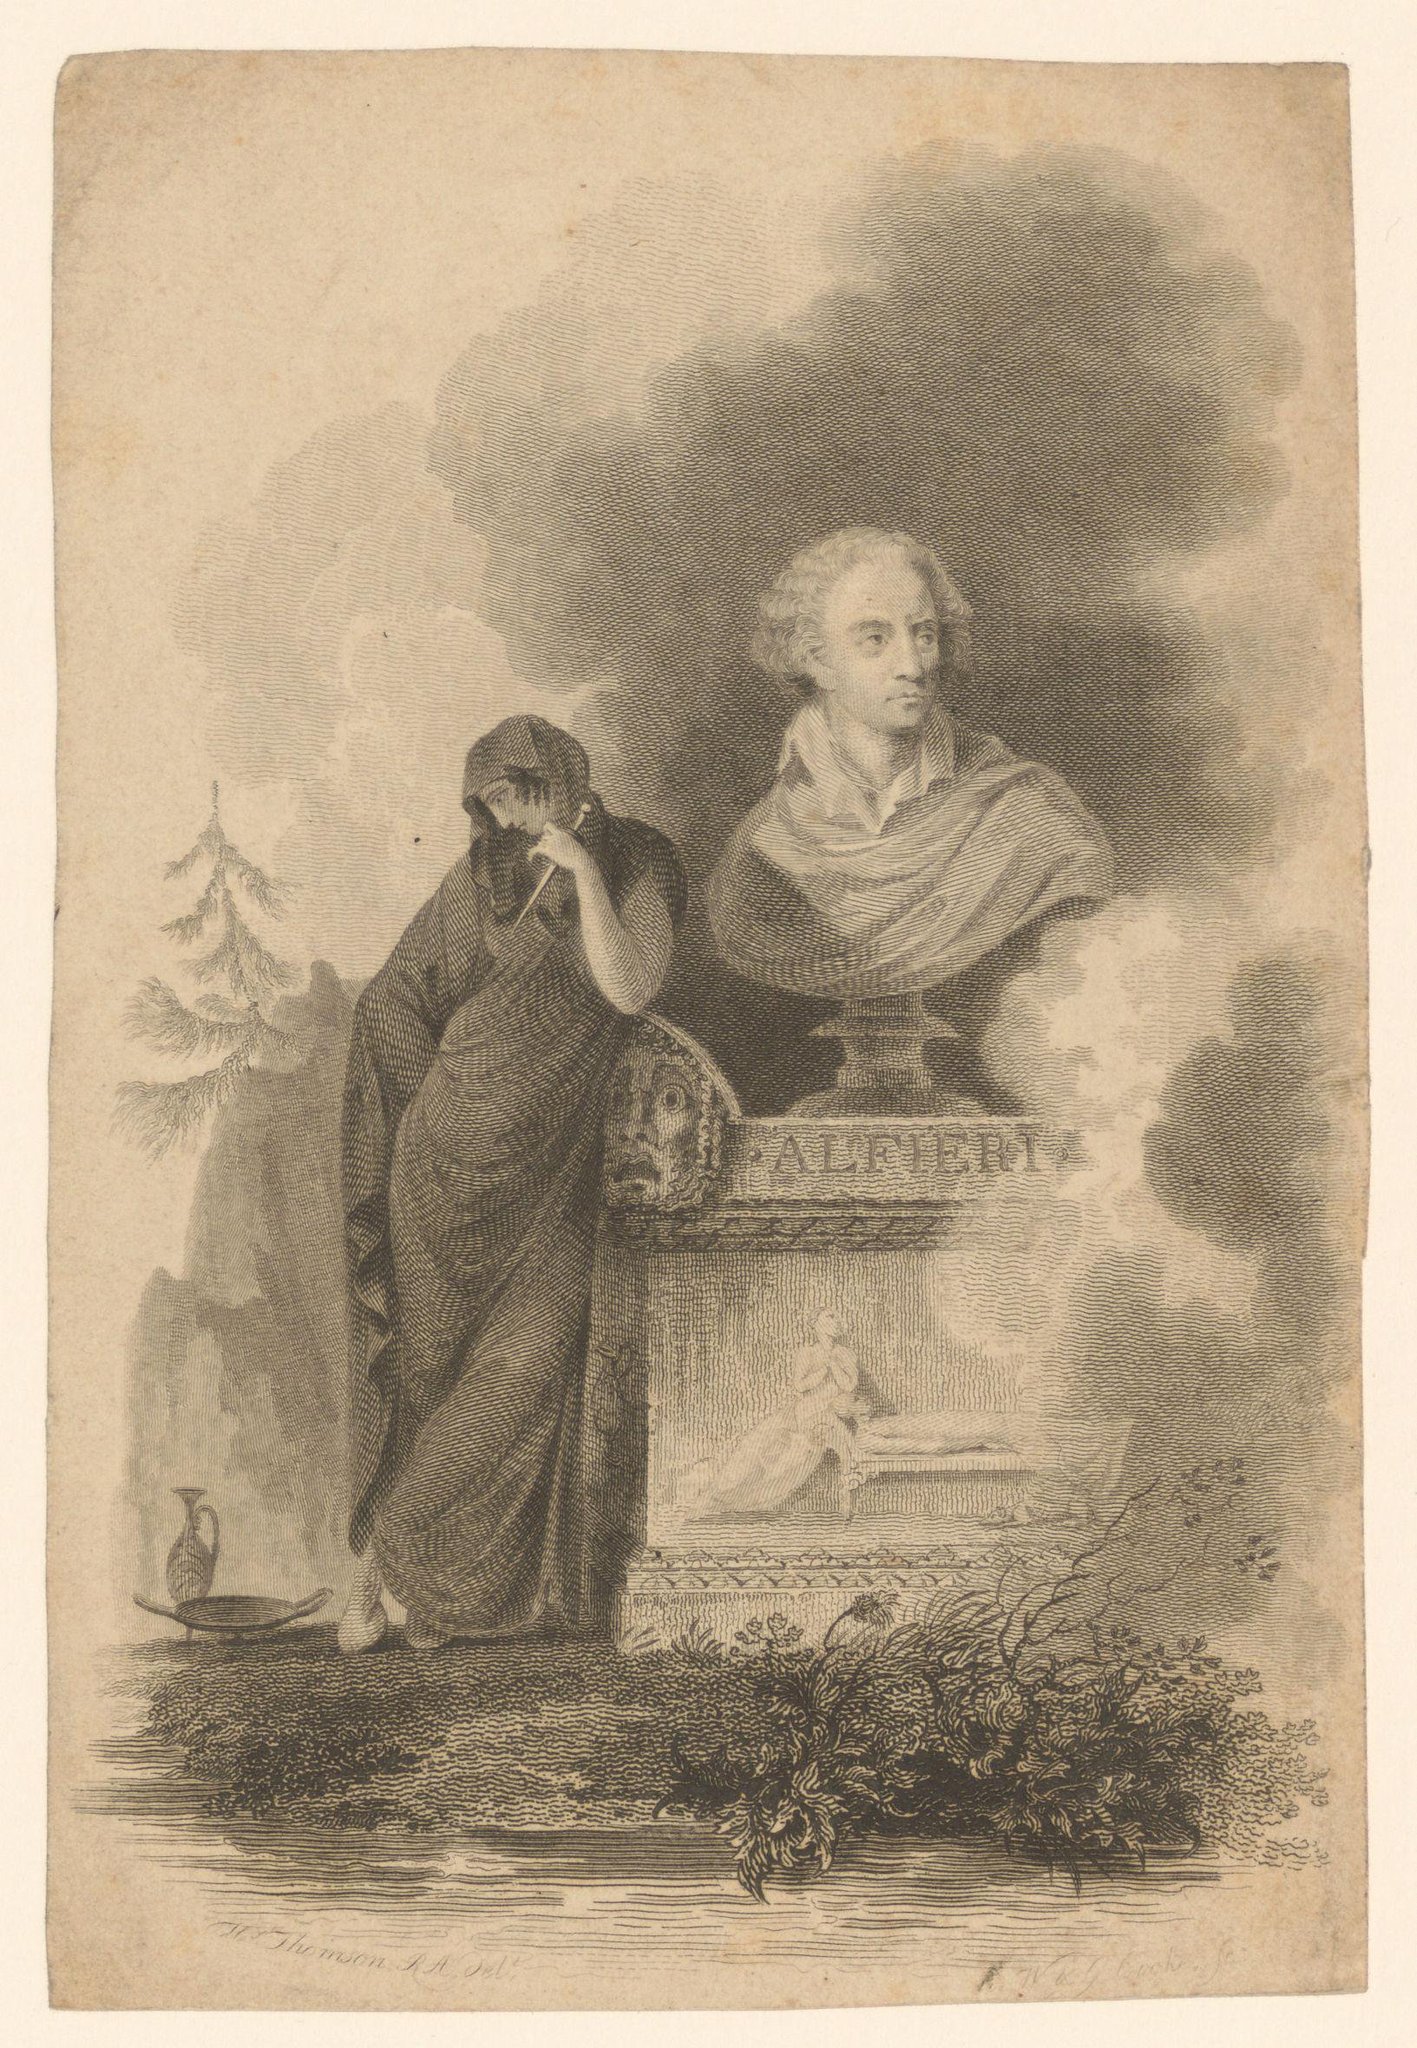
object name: print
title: Gesluierde vrouw leunt tegen portretbuste van Vittorio Alfieri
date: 1795-1810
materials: paper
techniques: etching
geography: london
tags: historical persons, portrait of a writer, single muses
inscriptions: collector's mark: Lugt 2228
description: Prent uit: Holcroft, Thomas. The Theatrical Recorder. Londen: Henry Delahoy Symonds, 1805, dl. 1.